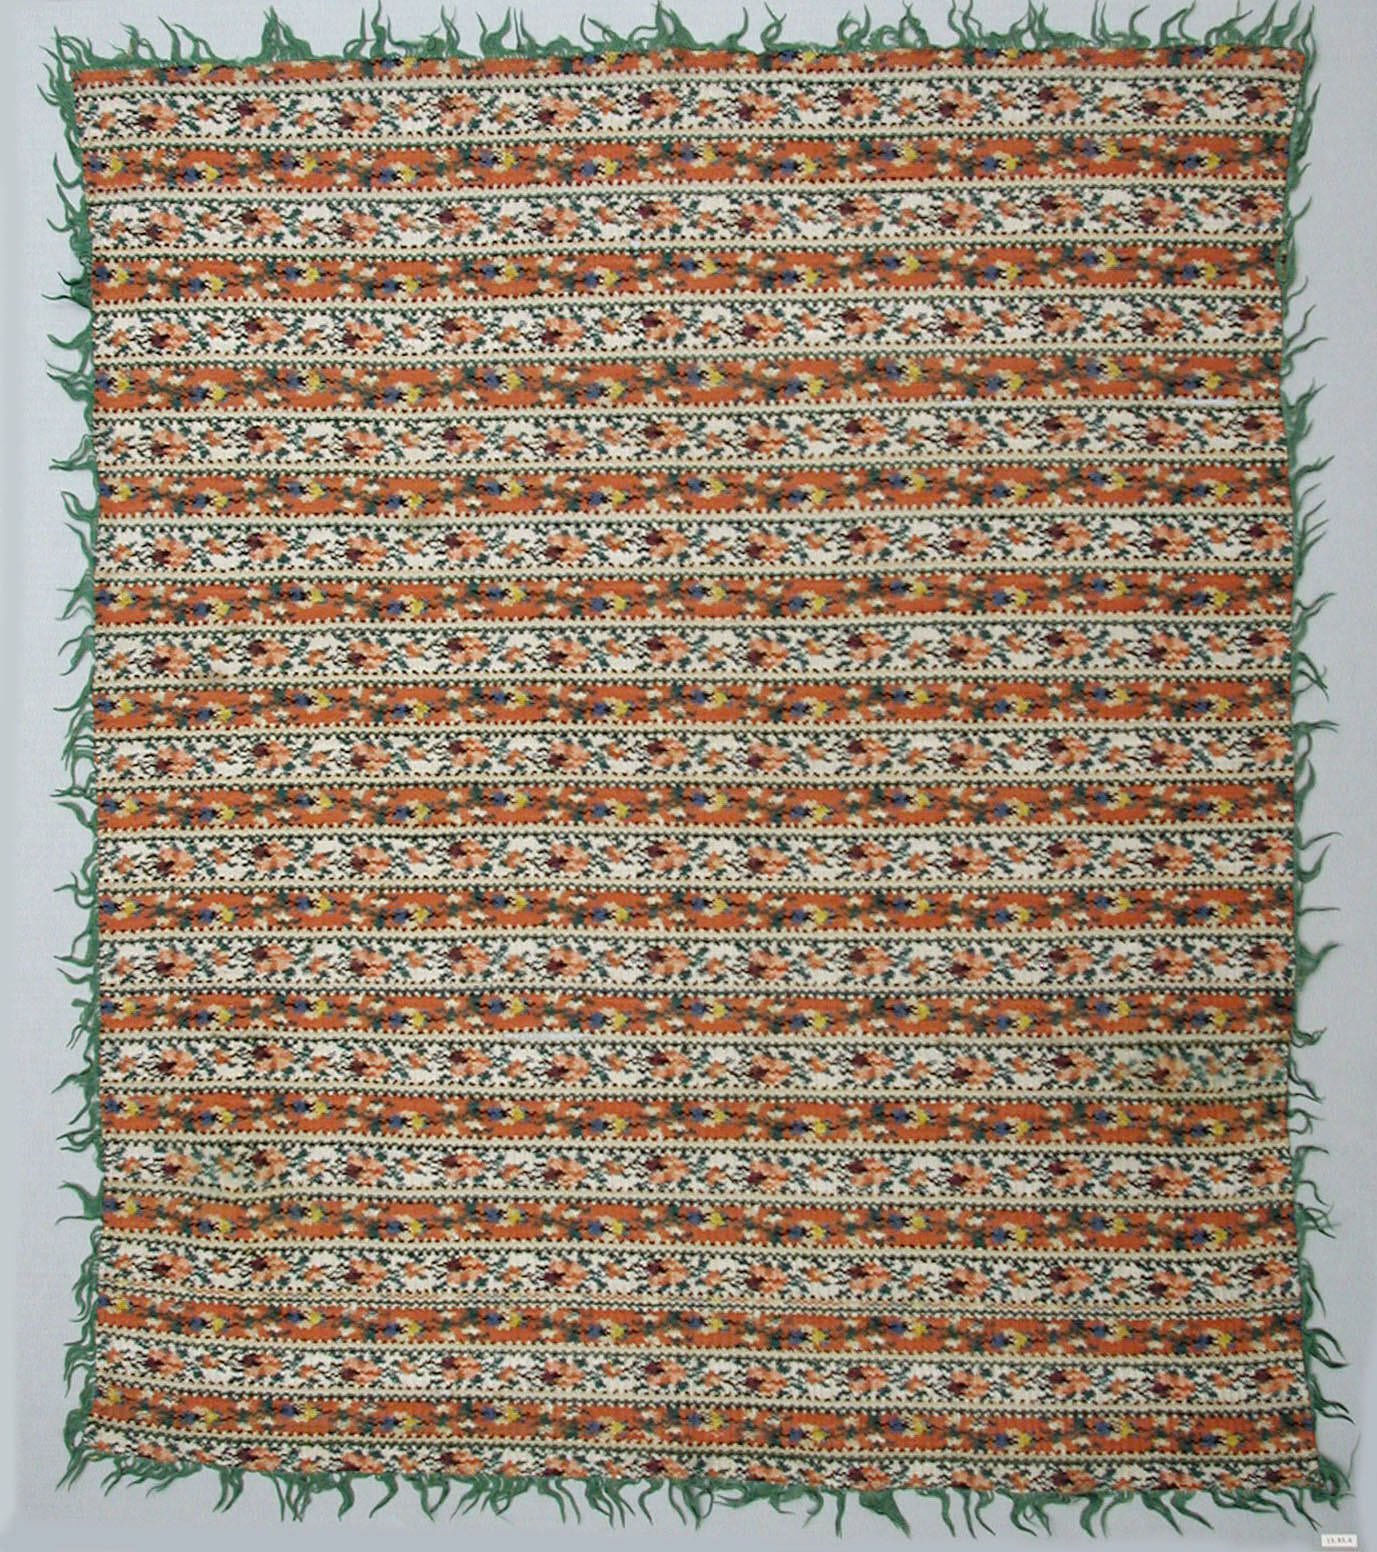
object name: shawl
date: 1701-1800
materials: silk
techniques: weave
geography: india